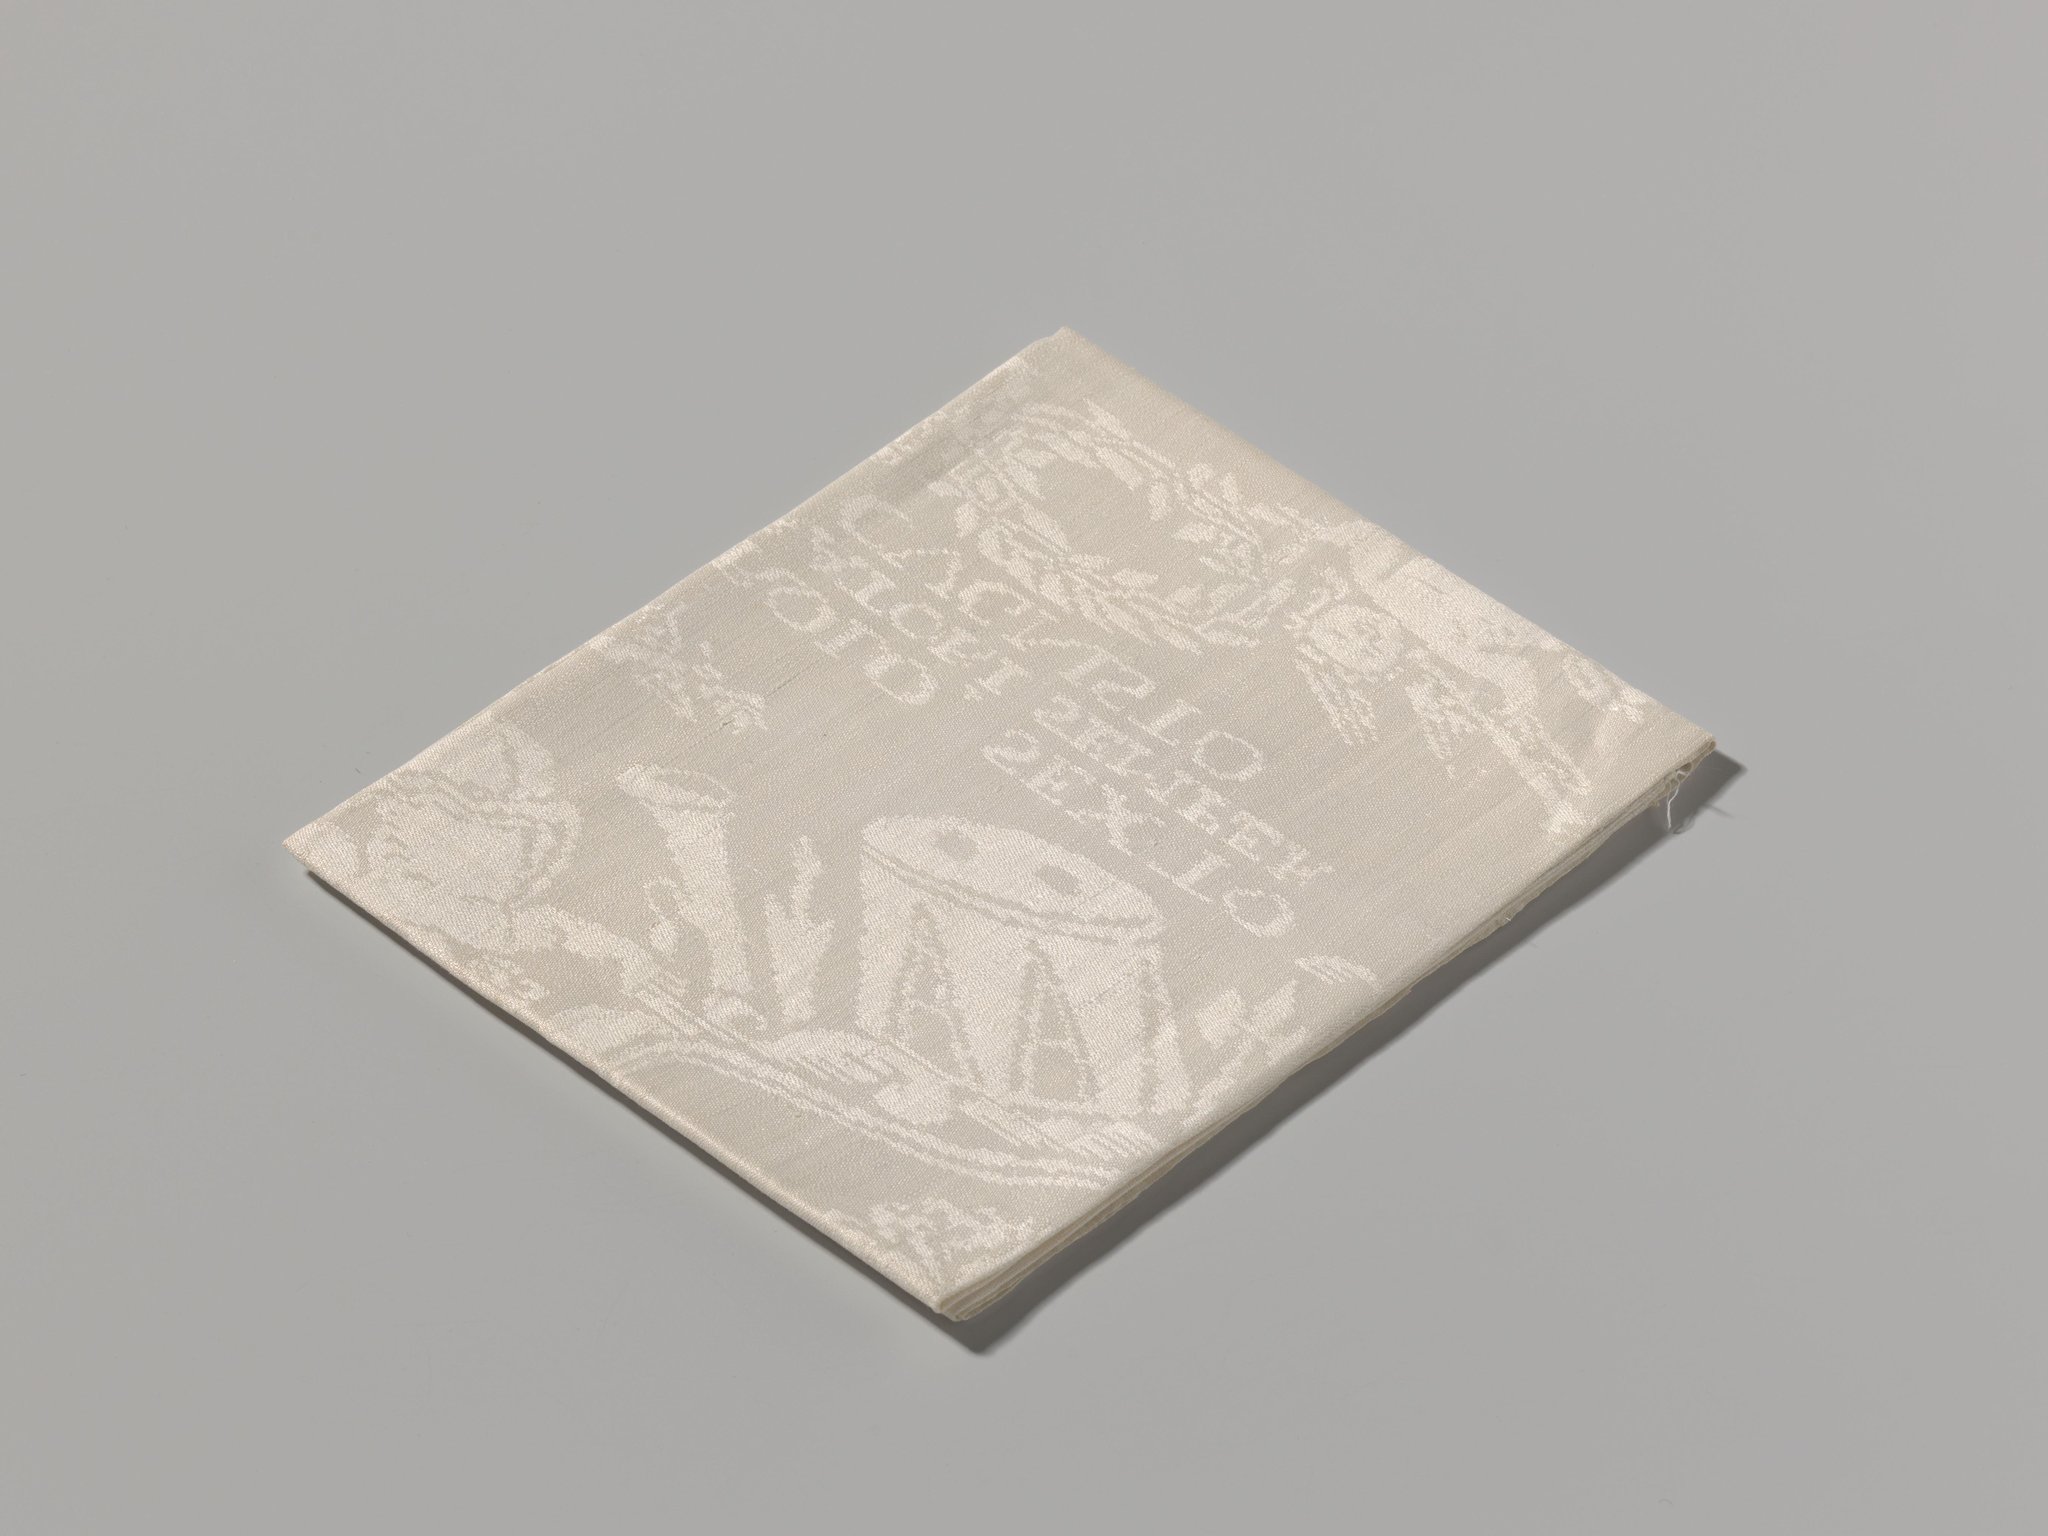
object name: napkin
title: Servet met Karel VI, Duits keizer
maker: Anonymous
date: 1711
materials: linen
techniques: damask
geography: kortrijk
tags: vienna, charles vi (holy roman emperor)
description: Servet van linnendamast met Karel VI, Duits keizer. Middenveld: het symmetrisch patroon vertoont van onder naar boven twee taferelen: 1 In het midden een levensboom (stellage met brandende pektonnen) en het woord pax. Ter zijde een vorst met scepter die de hand reikt aan een vorstin. 2 Wapen van Karel VI, Duits keizer, met de dubbele adelaar en het opschrift CAROLO SEXTO IMPERATOR SEMPER CVGNSTO. Staande randen: symmetrische cartouches waarbinnen burchten met de bijschriften: Bethune, Ostende, Bouchain, Donay, Aet, Meenen, Lille. Liggende randen: smalle rand met cirkels.